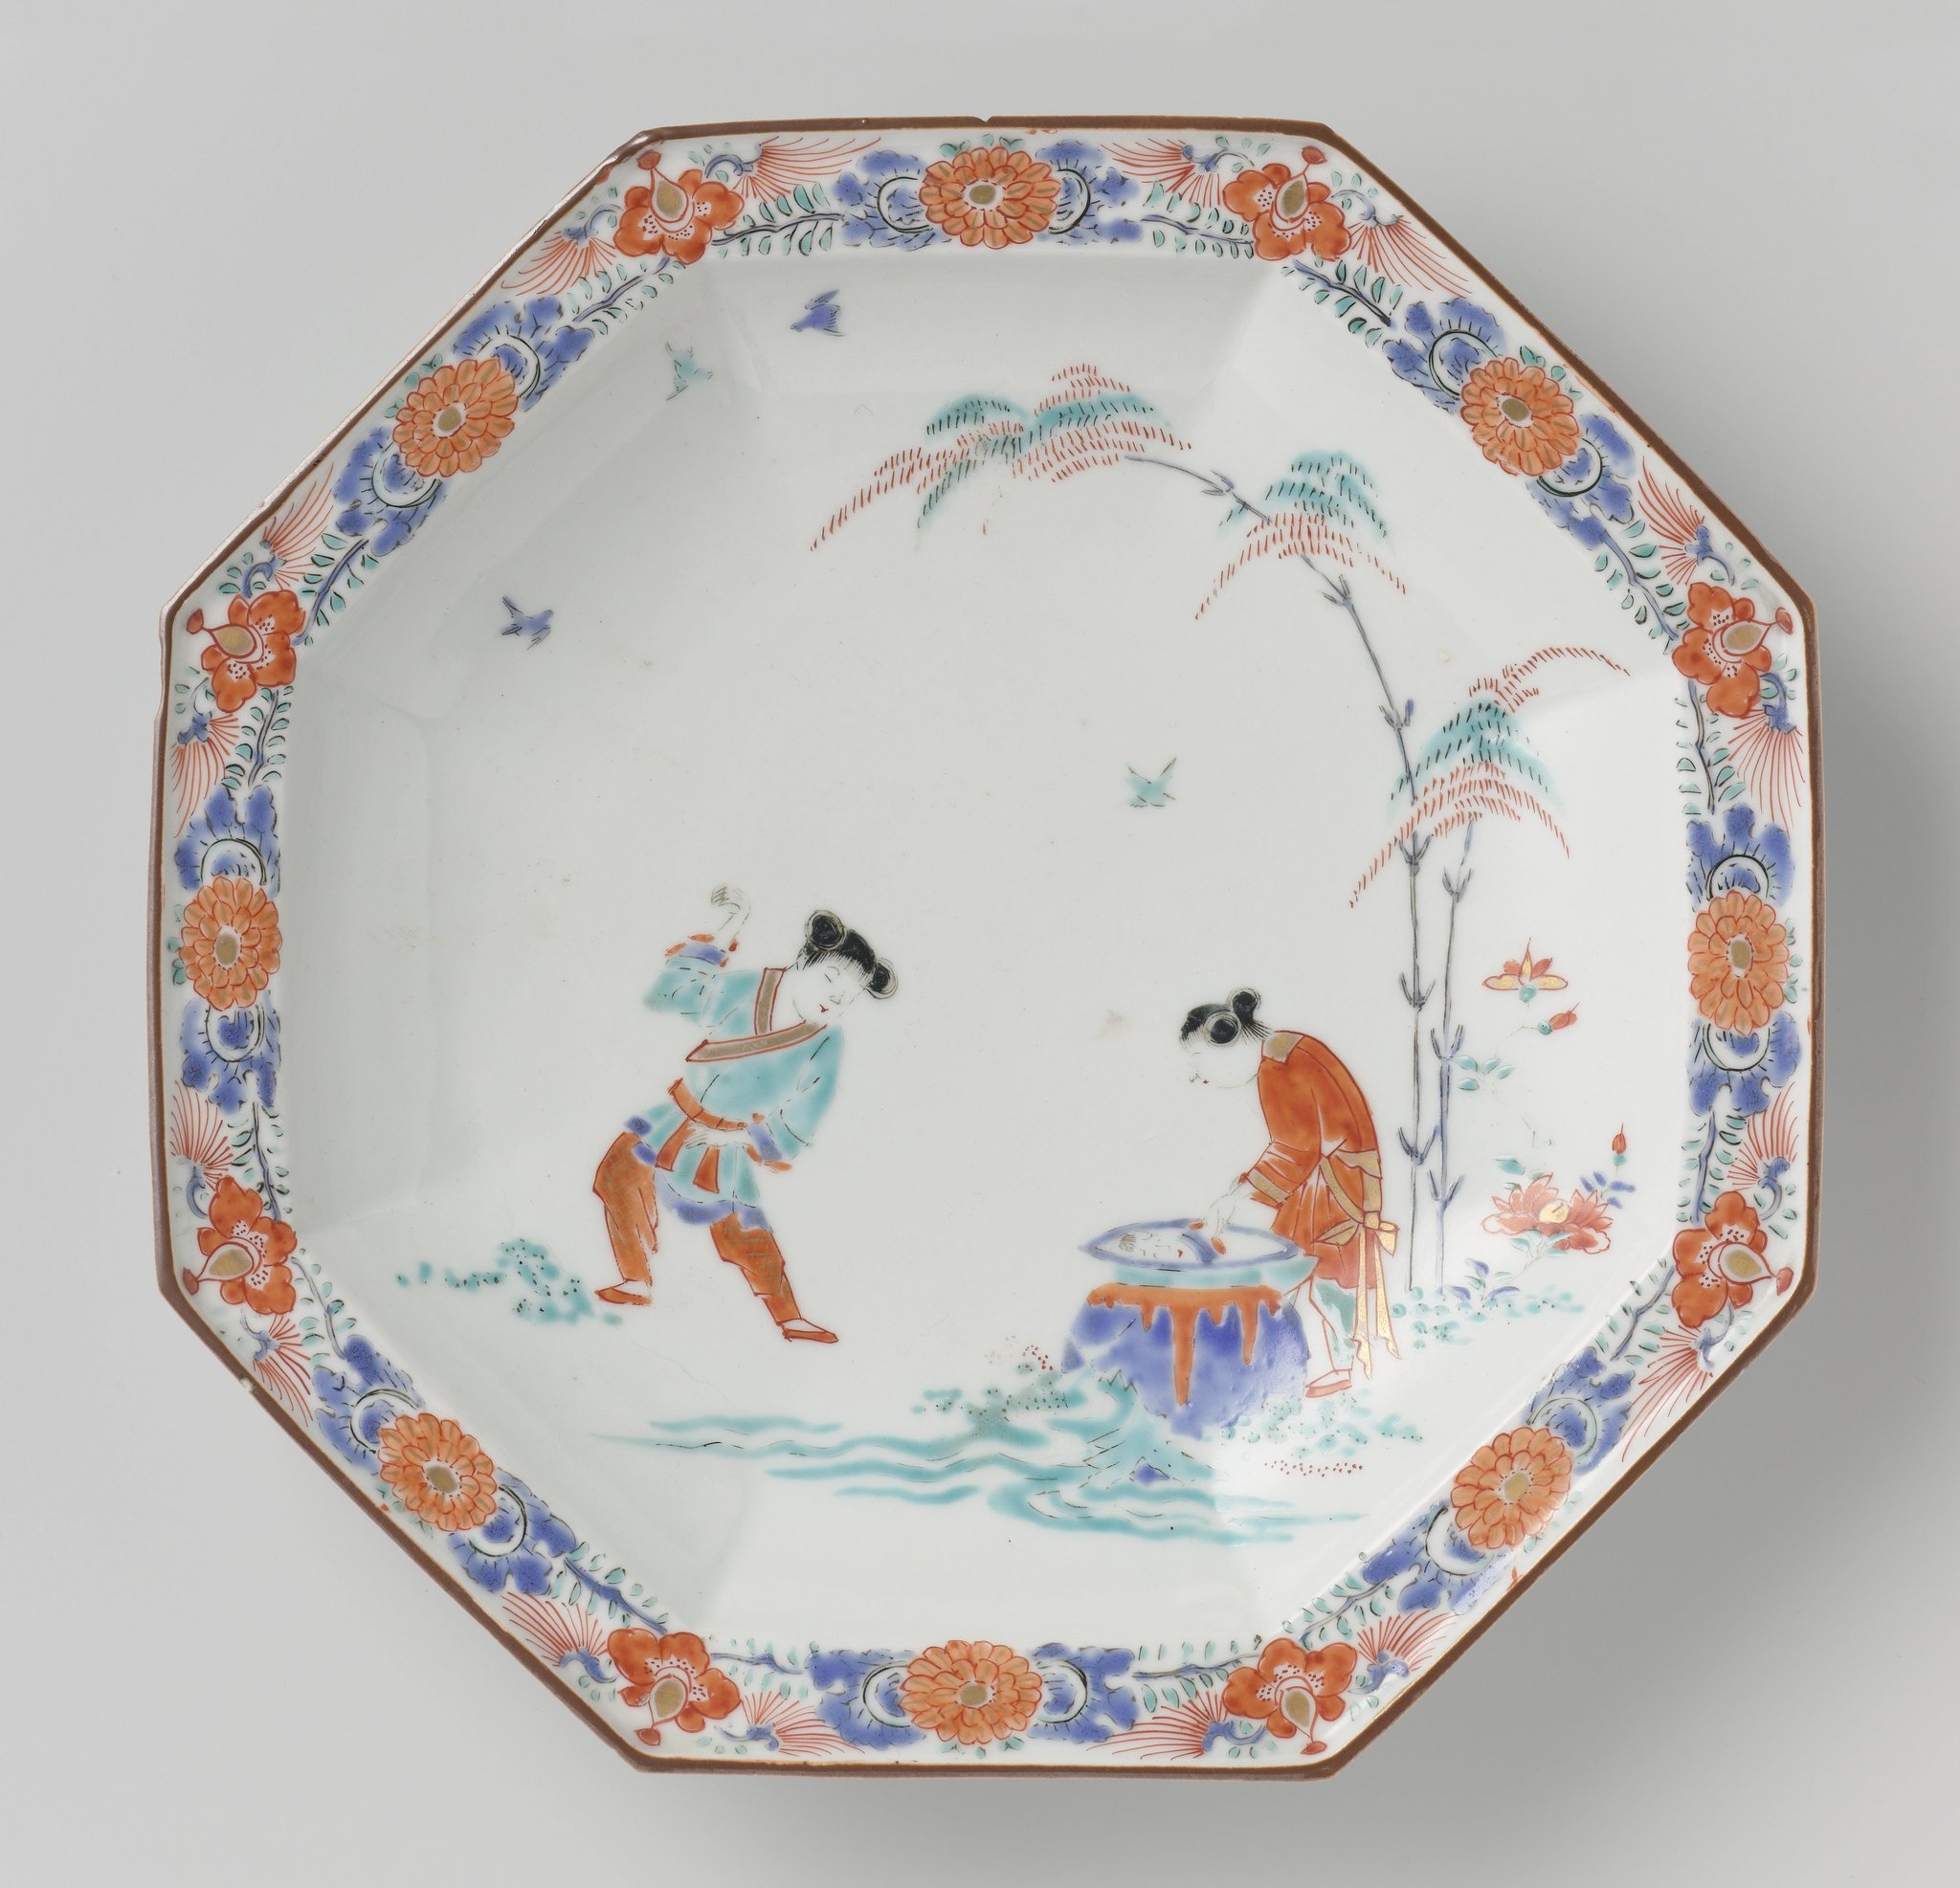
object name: plate dish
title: Octagonal plate with an image of Shiba Onko and floral scrolls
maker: Anonymous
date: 1670-1690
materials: glaze, gold, paint, porcelain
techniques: firing, forming, gilding, turning, vitrification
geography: japan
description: A Chinese boy, Sima Guang, saves a boy who is in danger of drowning in a large vat of water. Another child tries in vain to pull the boy out, but Sima Guang (at left) breaks the vessel by throwing a rock at it. He would later become a celebrated statesman, renowned for his quick wit. In Europe this motif – known as the ‘Hob in the Well’ – was so popular that English, French and German porcelain factories also adopted it.